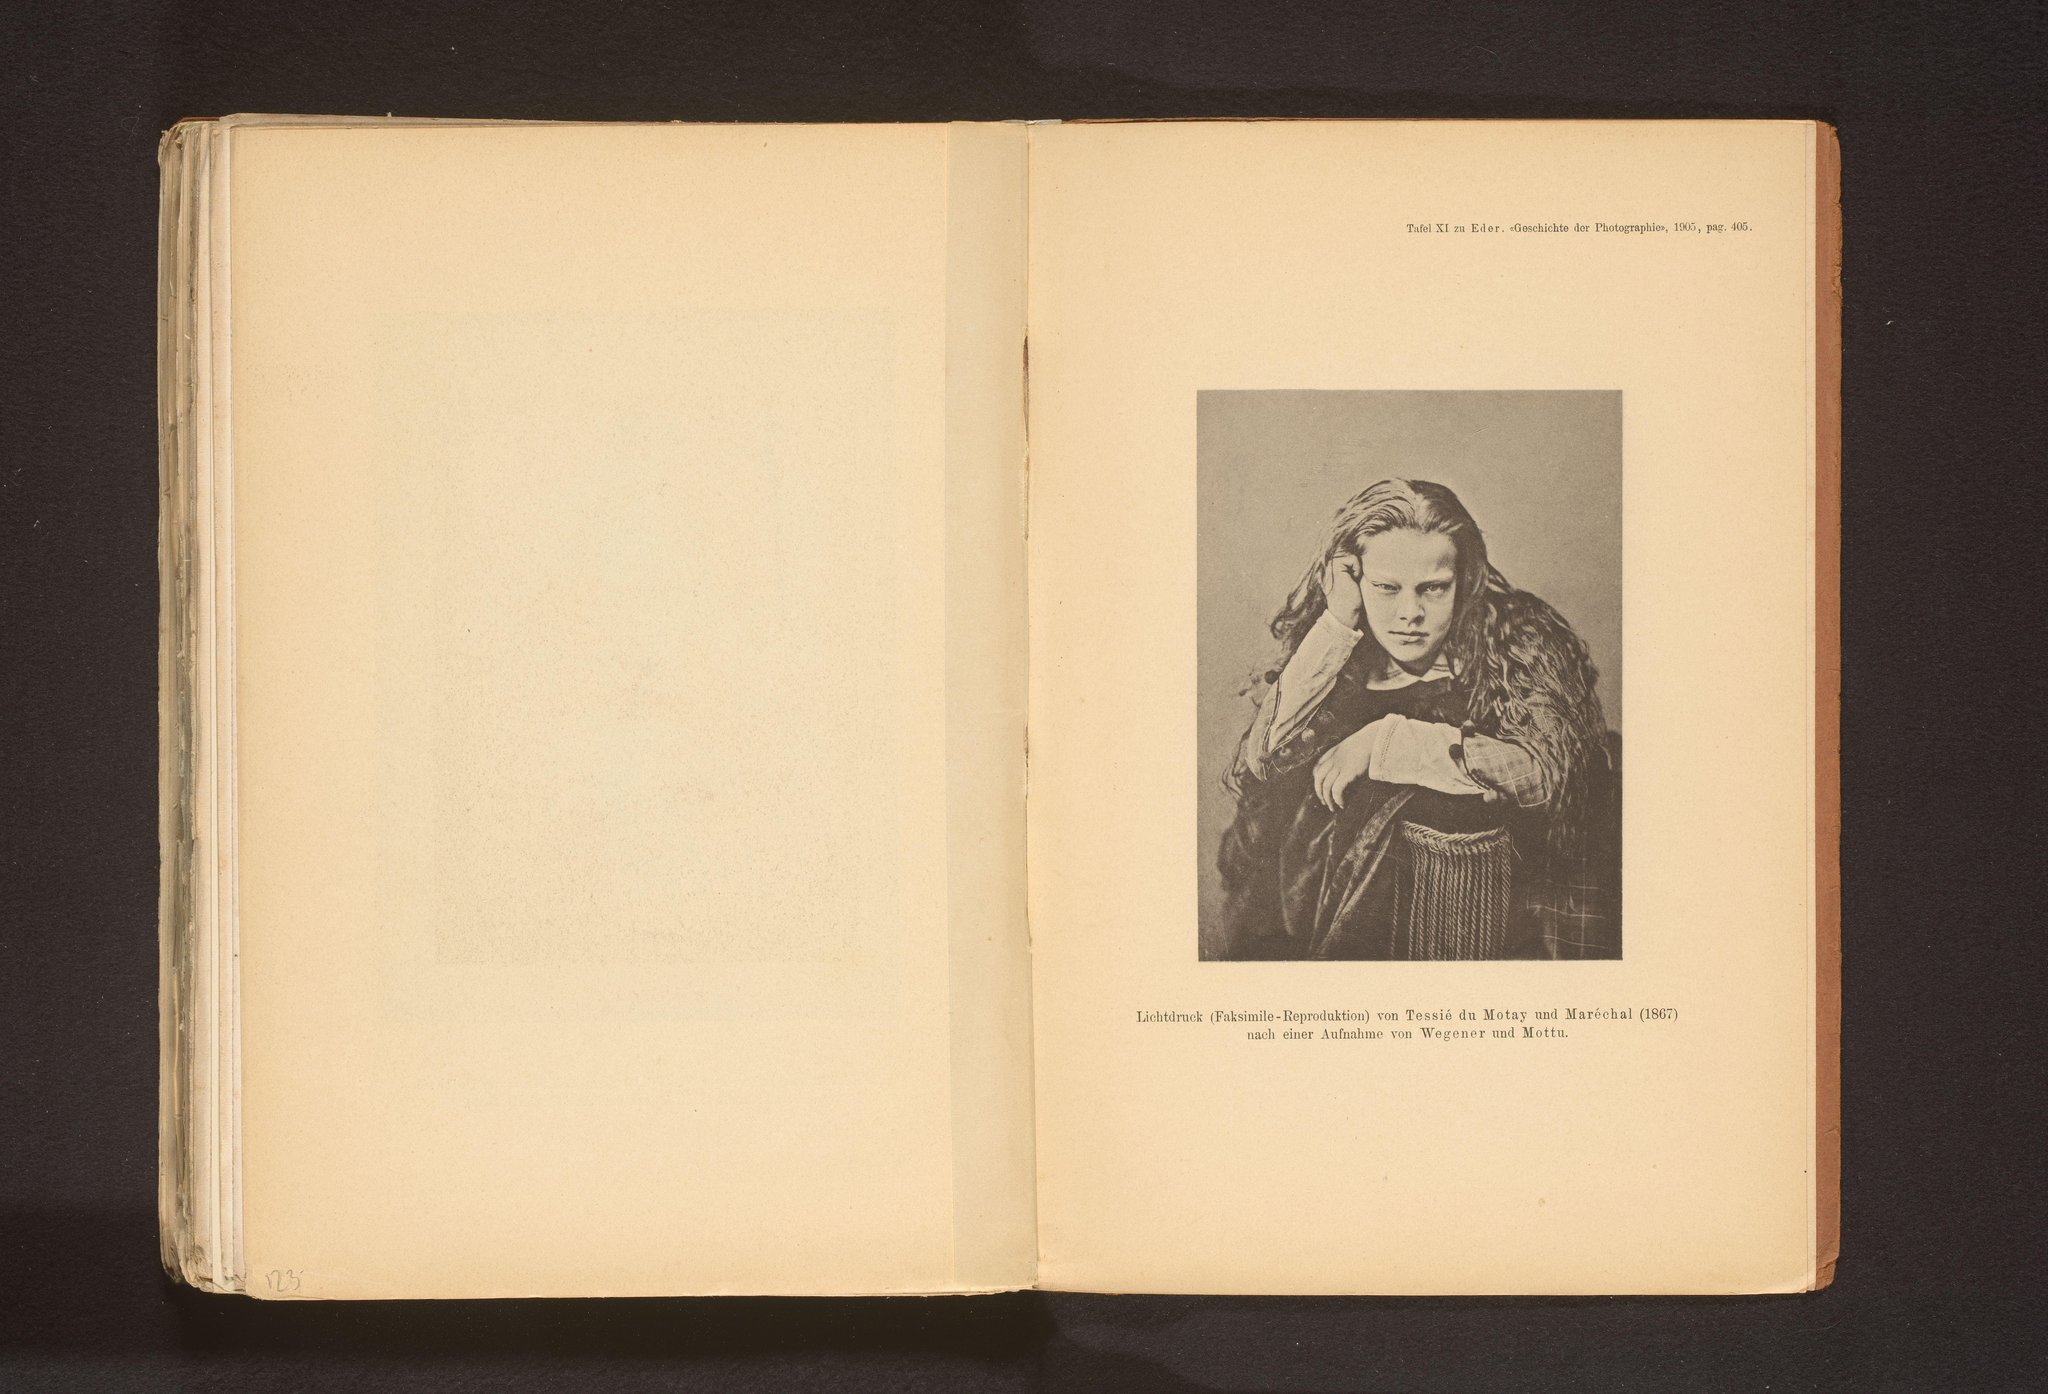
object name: page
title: Portret van een onbekend meisje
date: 1900-1905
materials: paper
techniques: photograph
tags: girl (child between toddler and youth)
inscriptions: number: ‘Tafel XI’, inscription: ‘Lichtdruck (...) Mottu.’